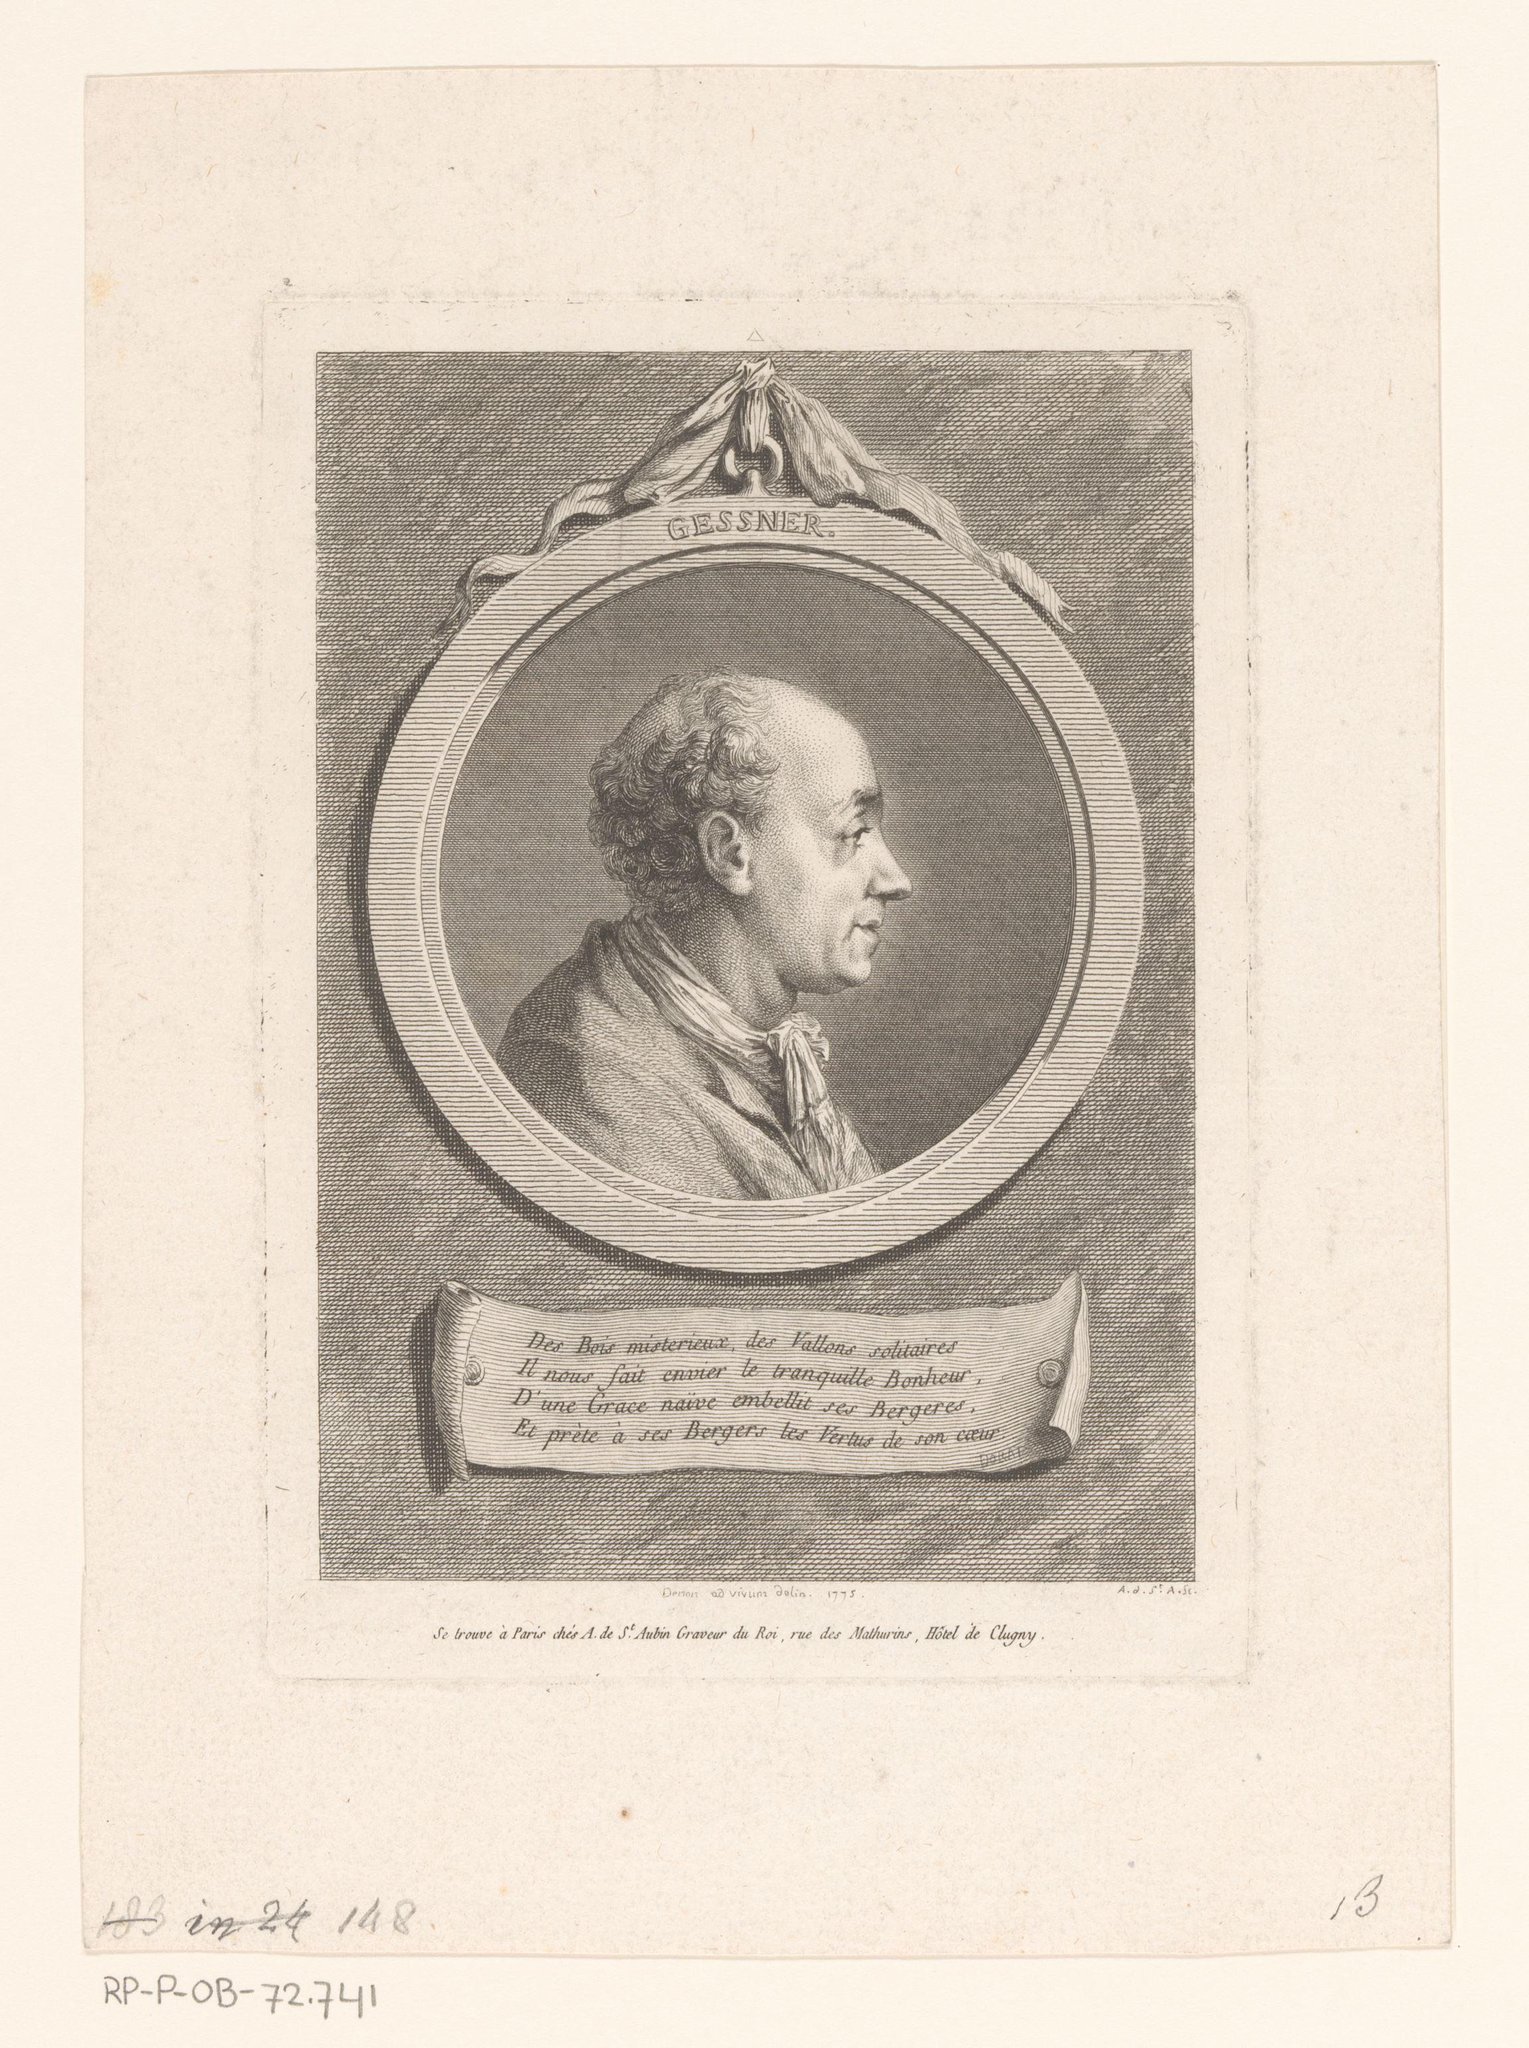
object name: print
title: Portret van Salomon Gessner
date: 1775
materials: paper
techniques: engraving, etching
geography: paris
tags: painter, salomon gessner, historical persons, portrait, self-portrait of painter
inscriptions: collector's mark: Lugt 2228